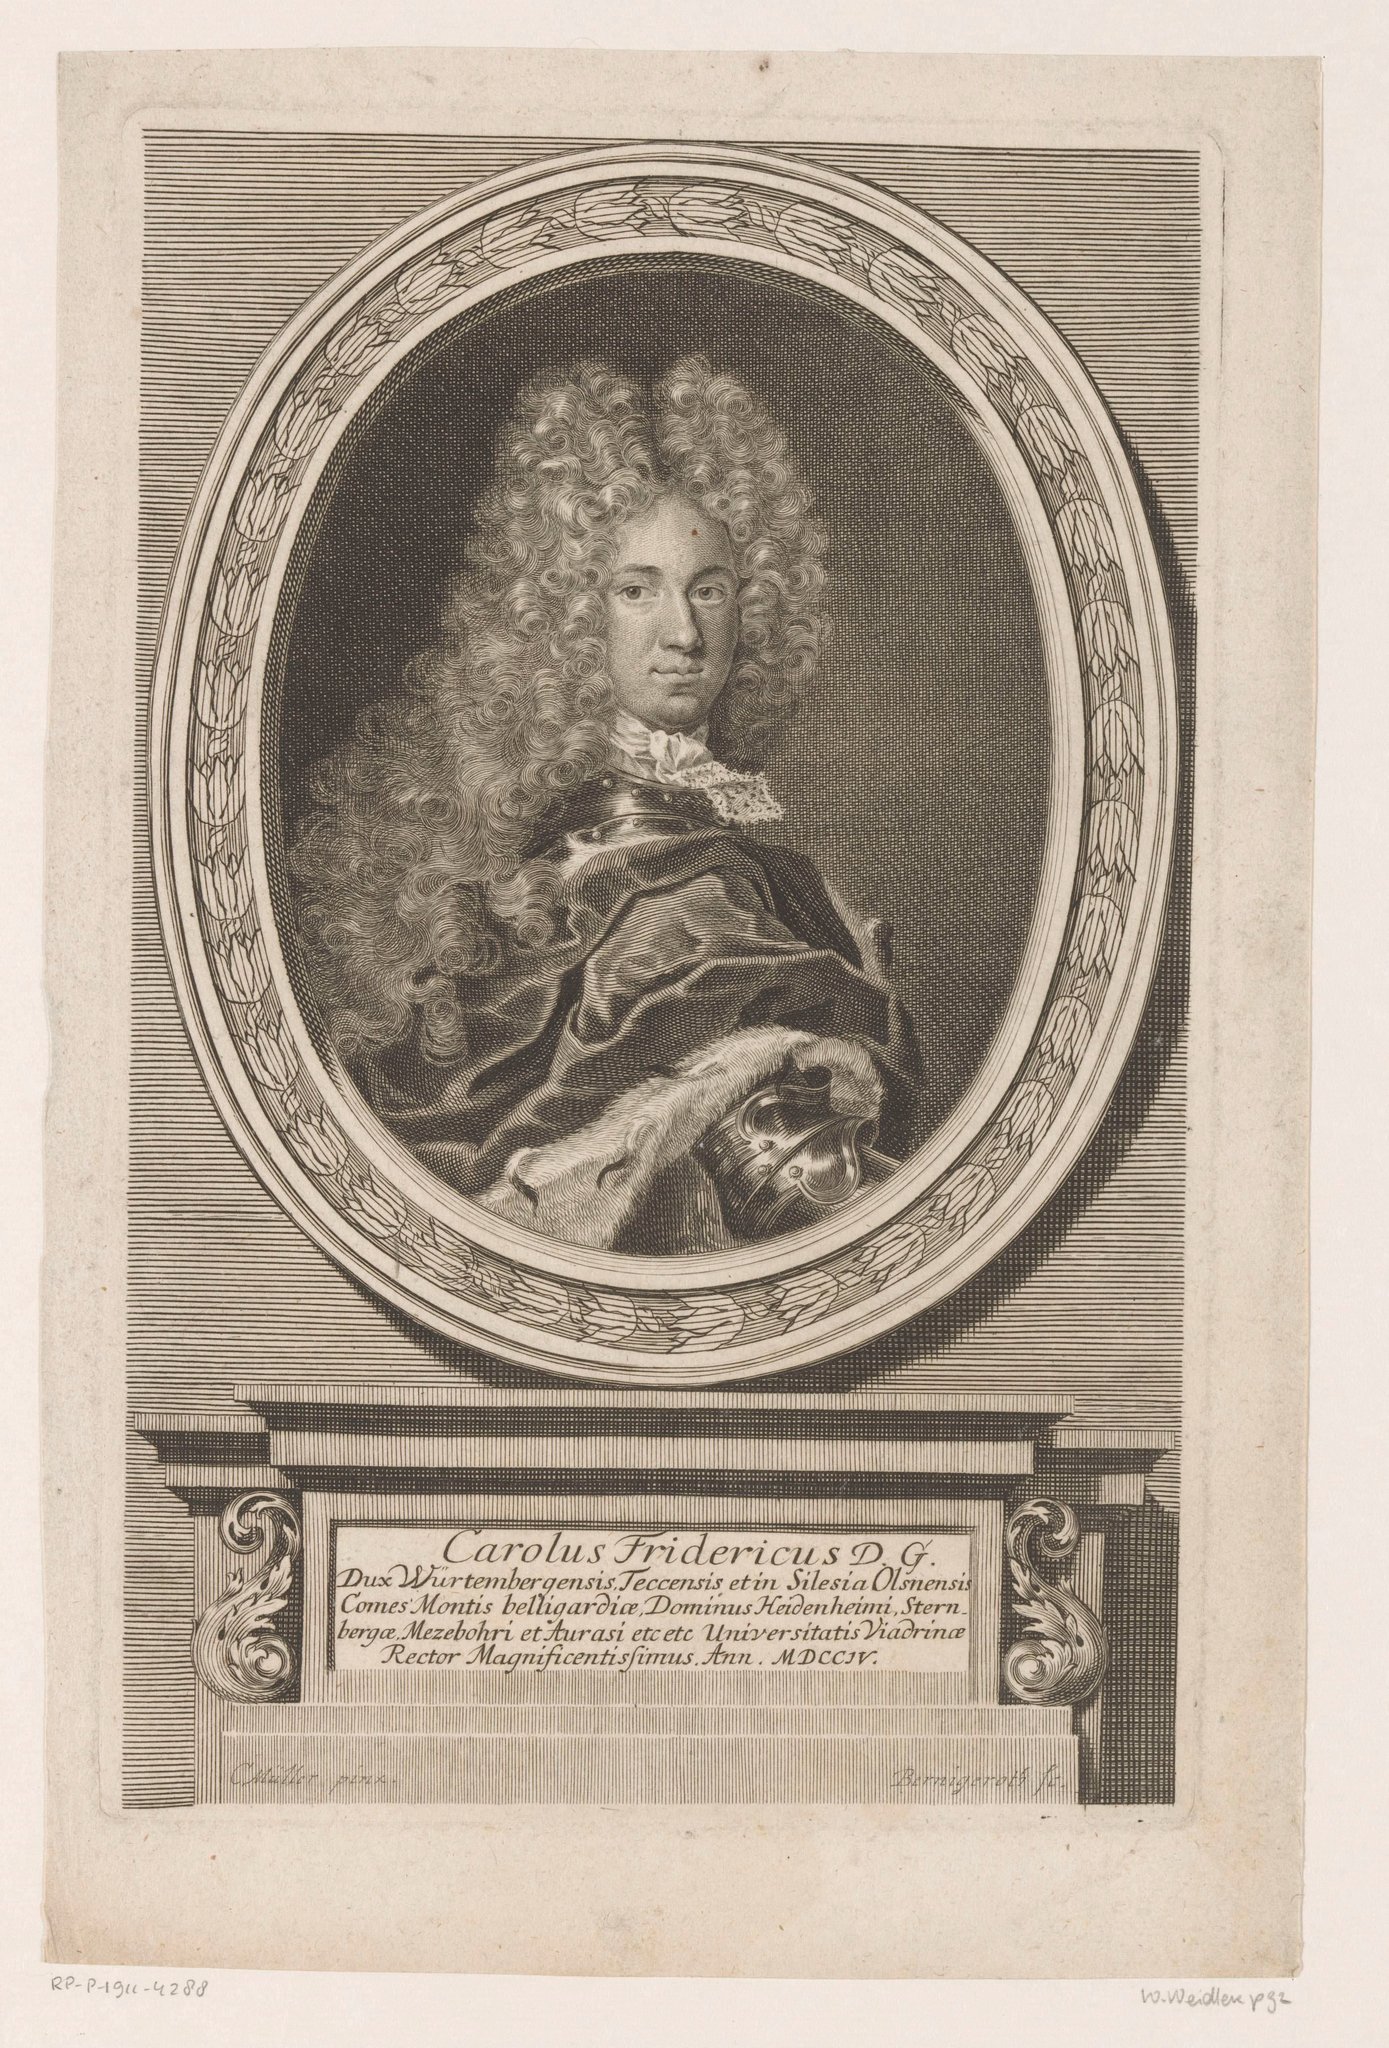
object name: print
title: Portret van Karl Friedrich von Württemberg-Oels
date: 1707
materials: paper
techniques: engraving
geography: leipzig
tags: armour, historical persons, mantle, gown, dress (symbol of sovereignty)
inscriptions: collector's mark: Lugt 2228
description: Prent ook gebruikt in: Beckmann, Johann Christoph. Notitia Universitatis Francofurtanae (...). Frankfurt an der Oder: erven Jeremias Schrey en Johann Christoph Hartmann, 1707.